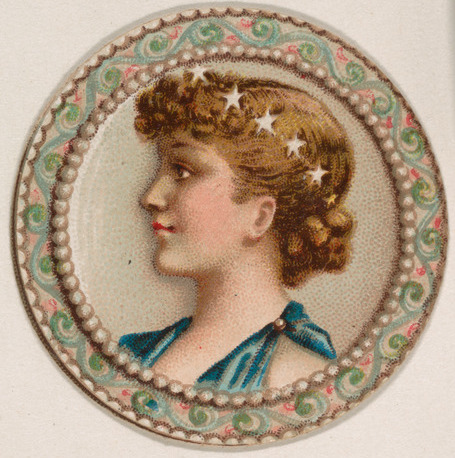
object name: print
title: Plate, from the Novelties series (N228, Type 3) issued by Kinney Bros.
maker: kinney brothers tobacco company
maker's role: publisher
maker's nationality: american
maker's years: 1869-2011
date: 1889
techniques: color lithograph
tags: profiles,women